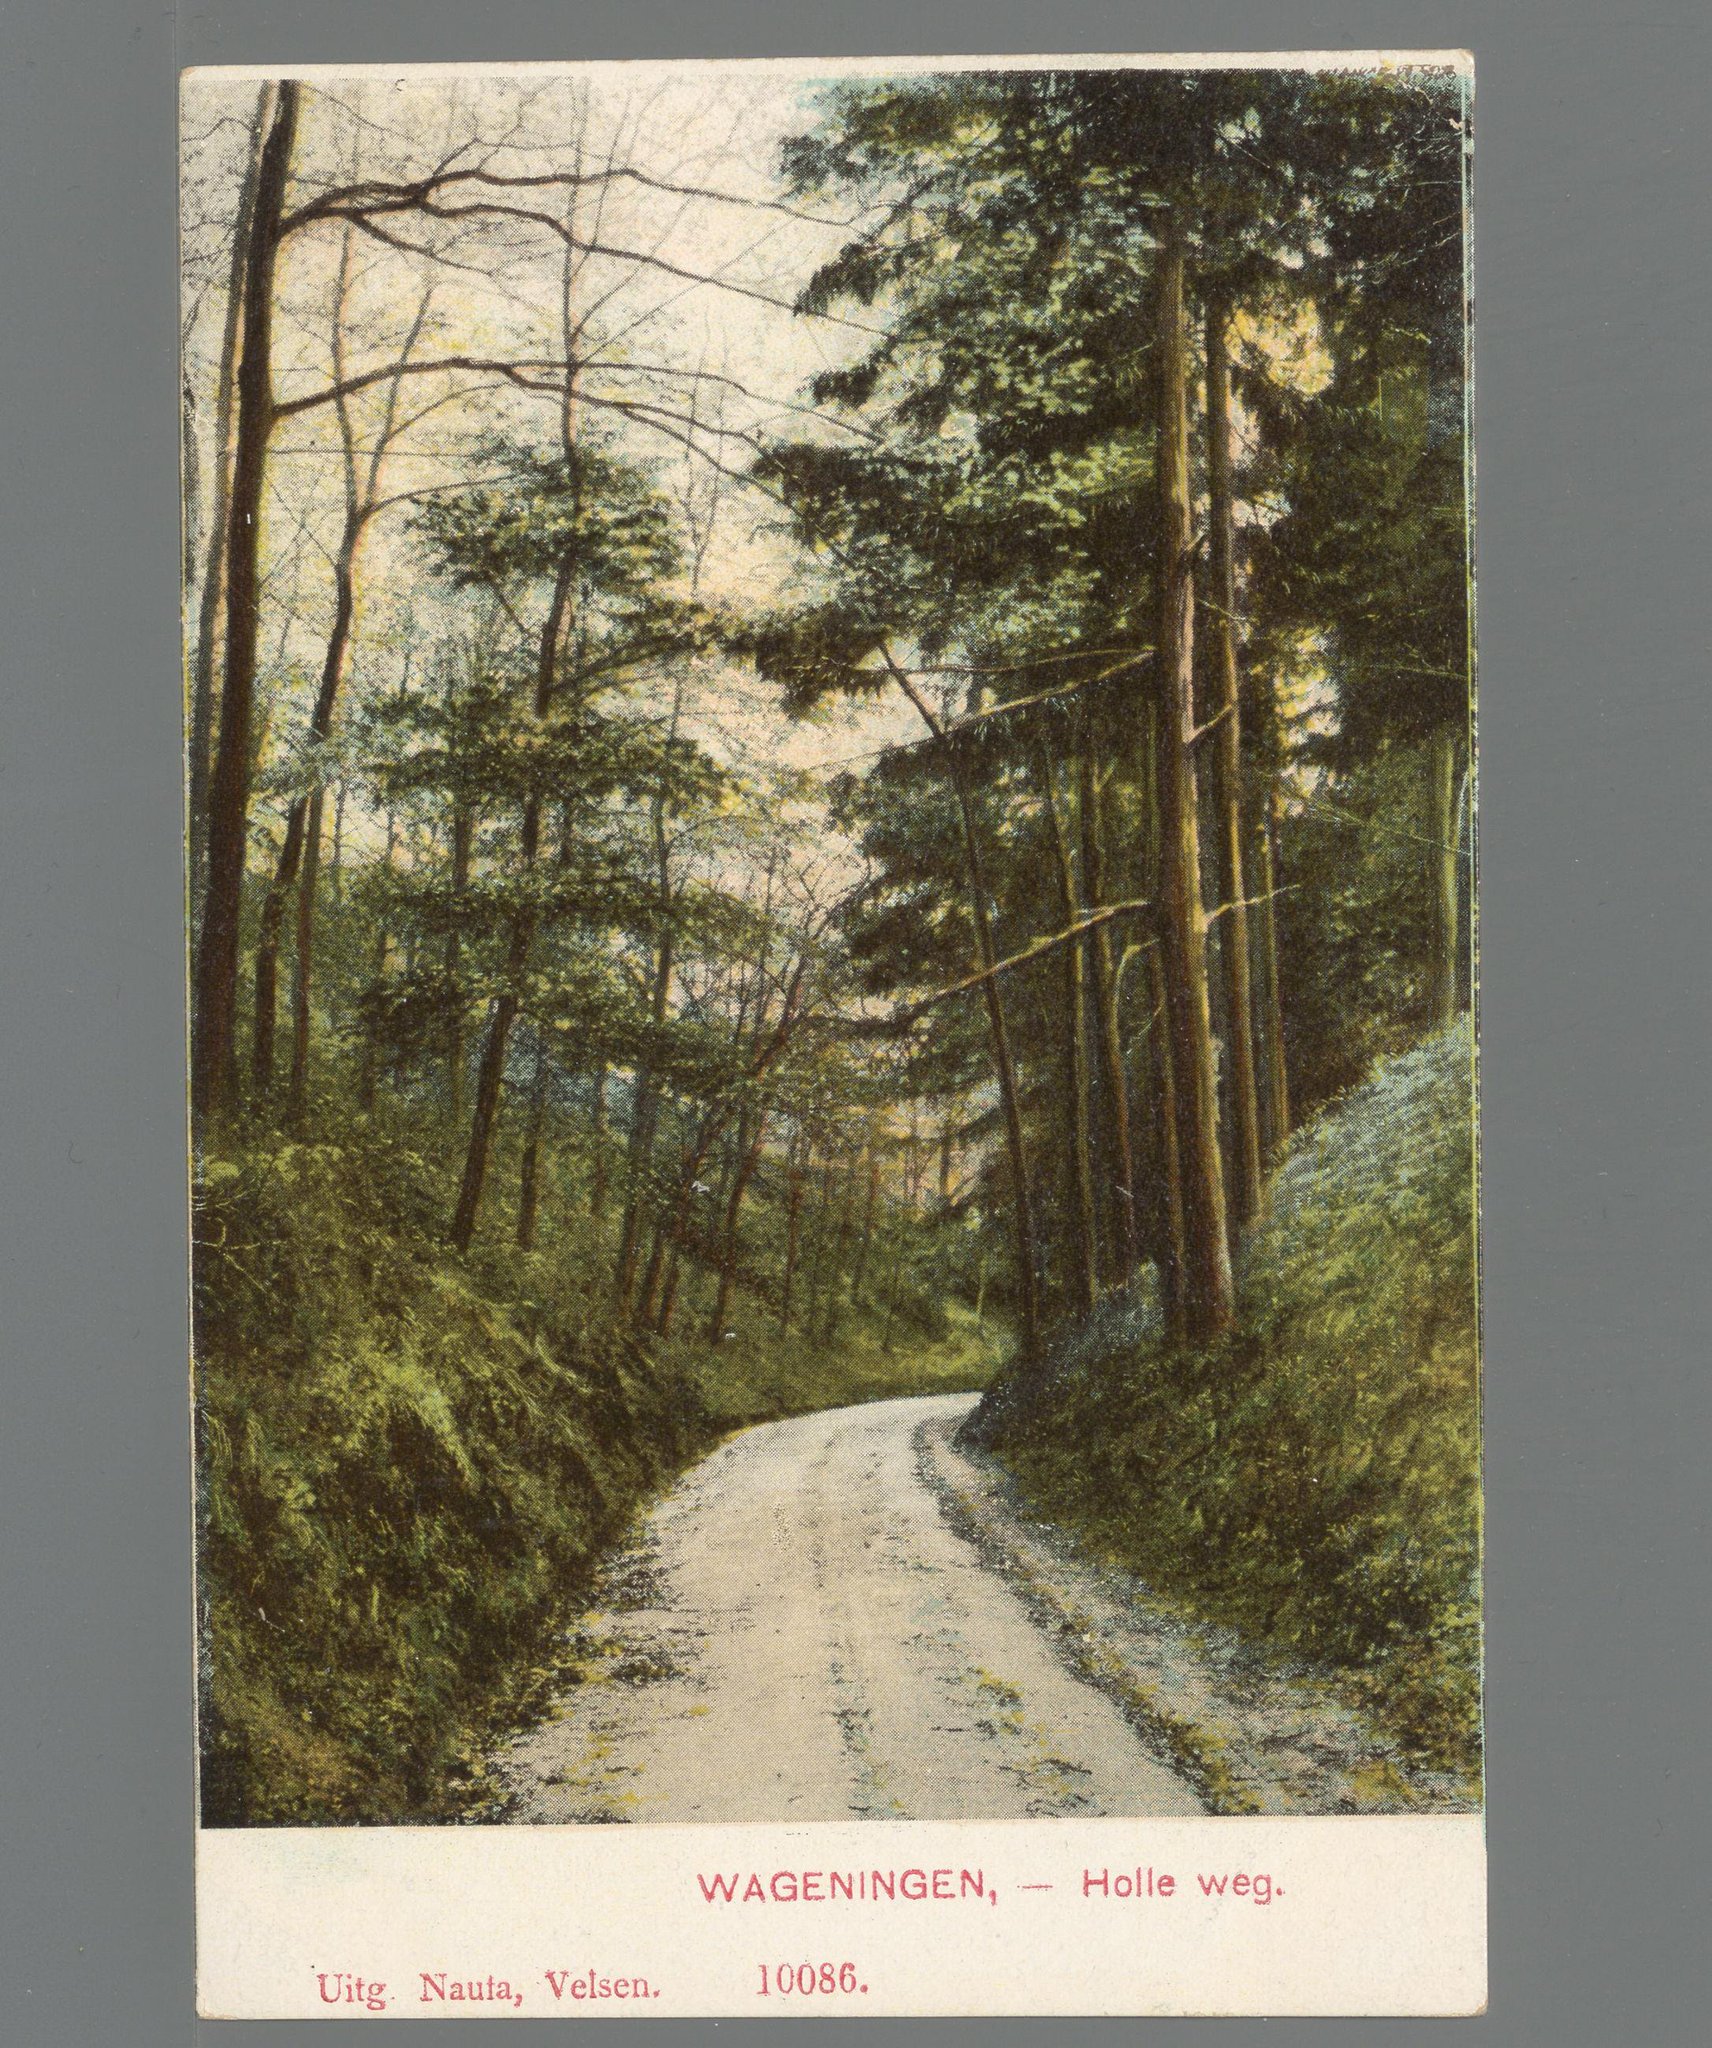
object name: photomechanical print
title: Wageningen, - Holle weg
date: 1905-1927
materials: cardboard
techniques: lithograph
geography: velsen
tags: forest path or lane